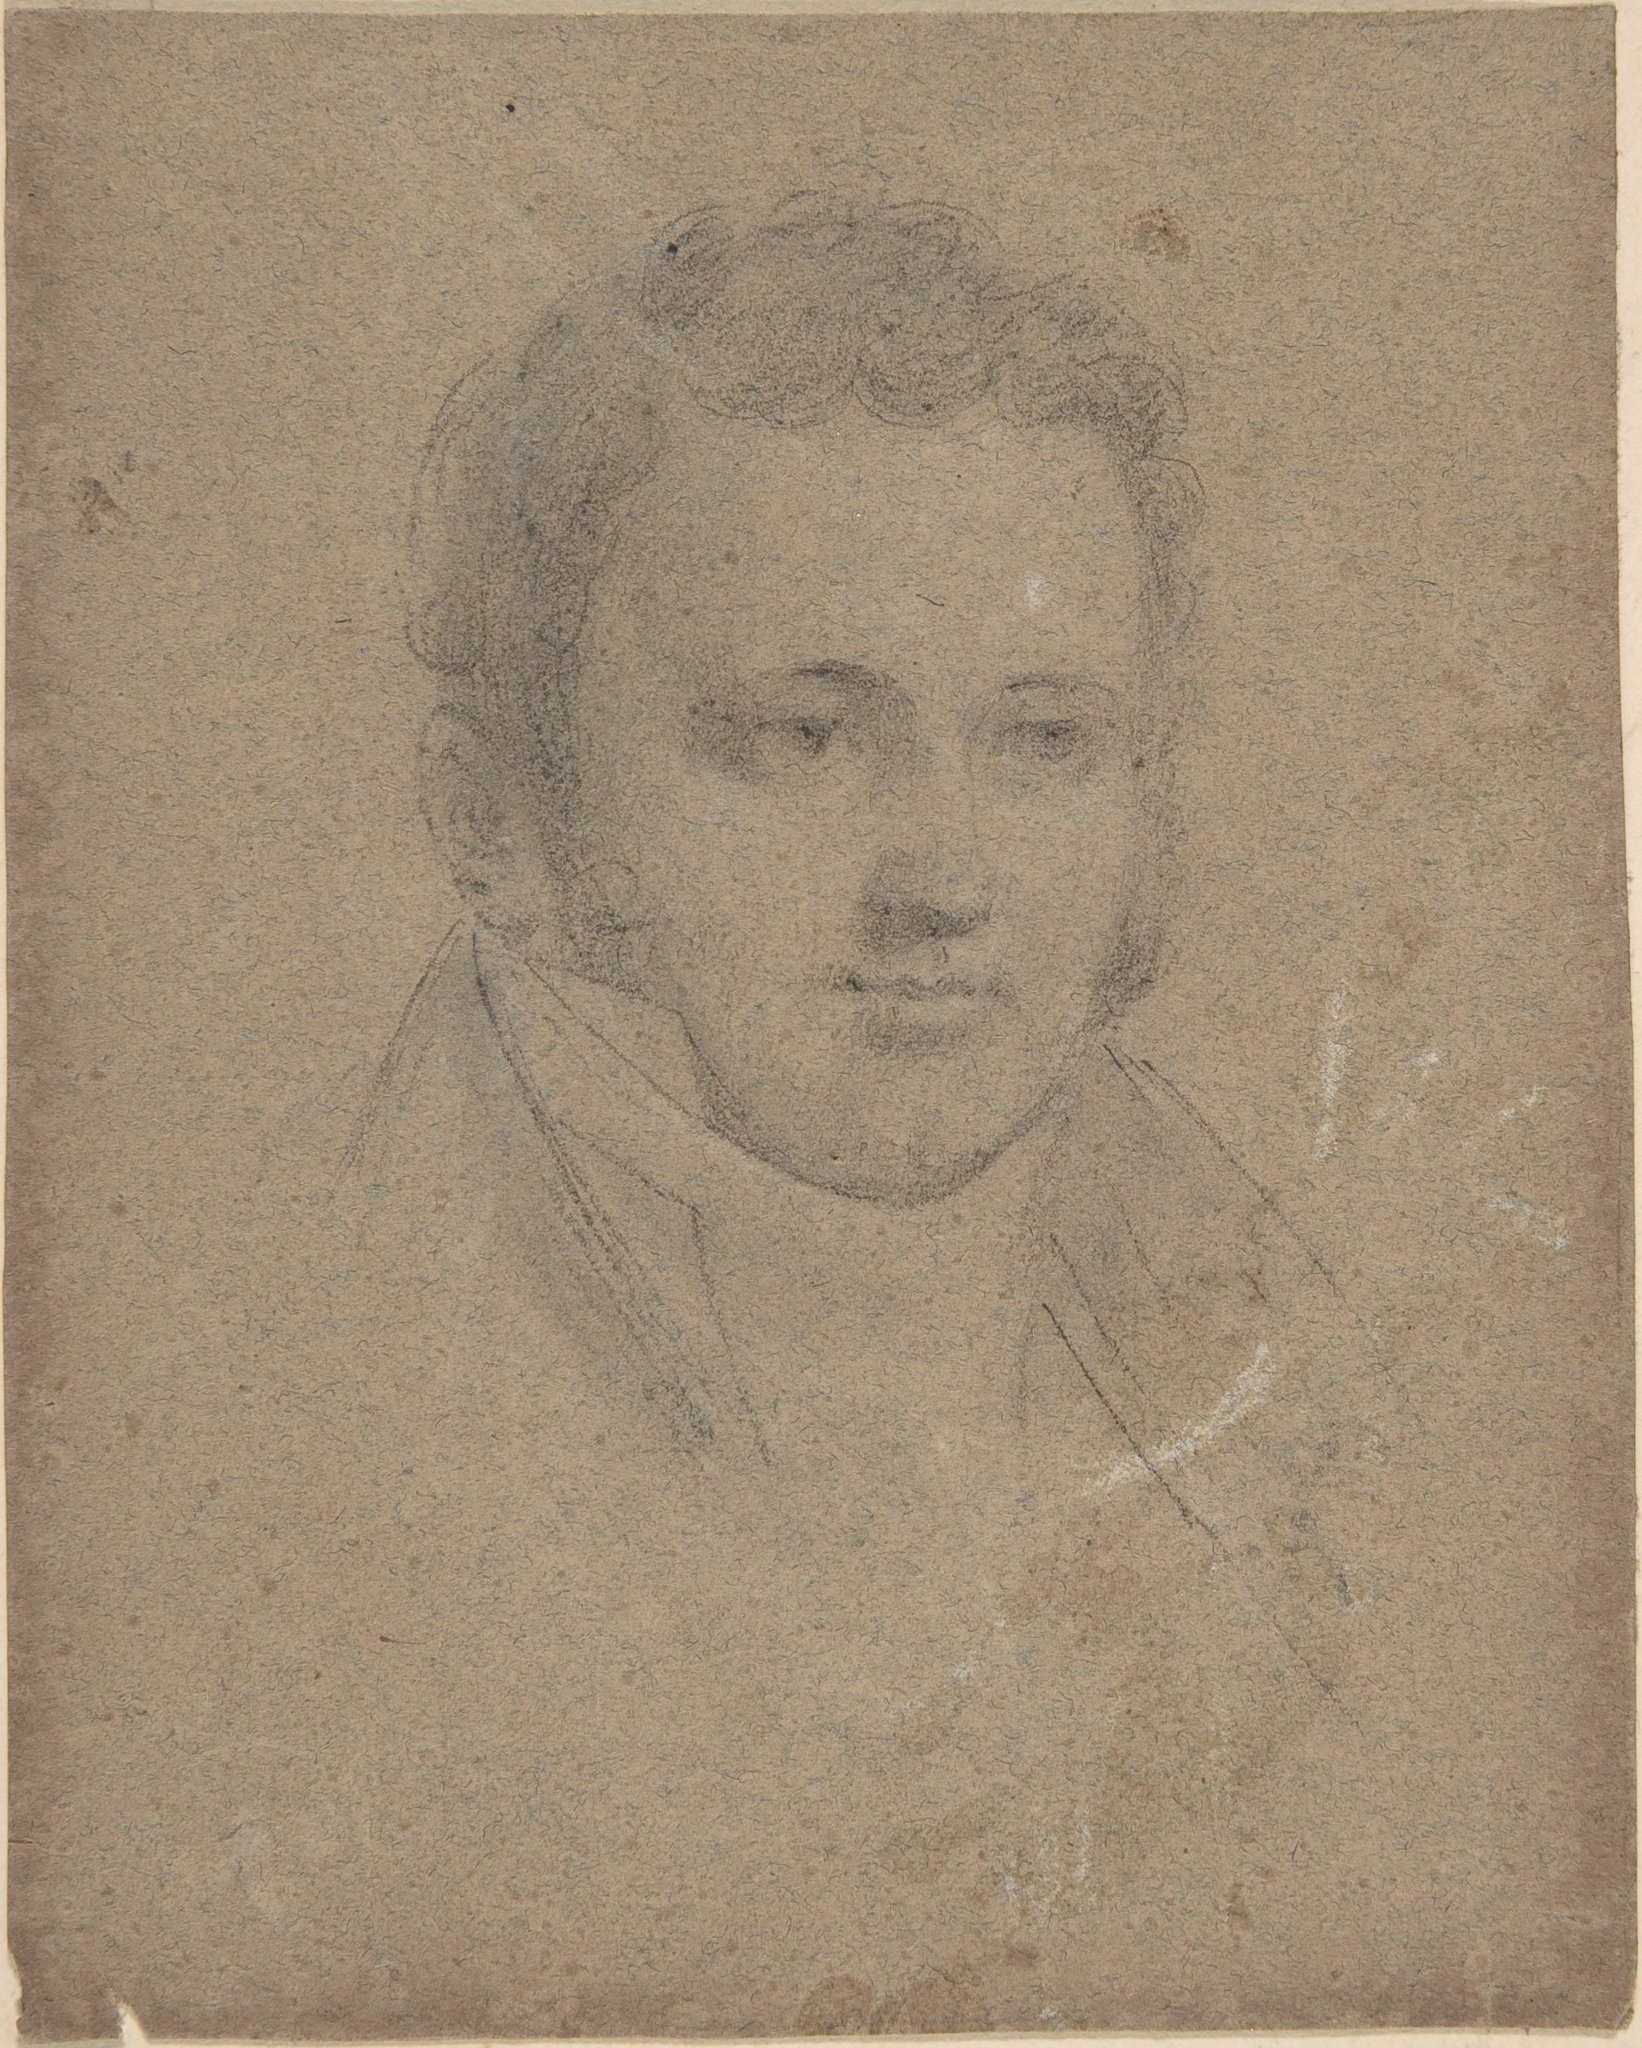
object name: drawing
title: Marchand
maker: anonymous, french, 18th century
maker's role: artist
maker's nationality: french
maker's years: 1700-1800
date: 1701-1800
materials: chalk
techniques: stumping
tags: men,portraits